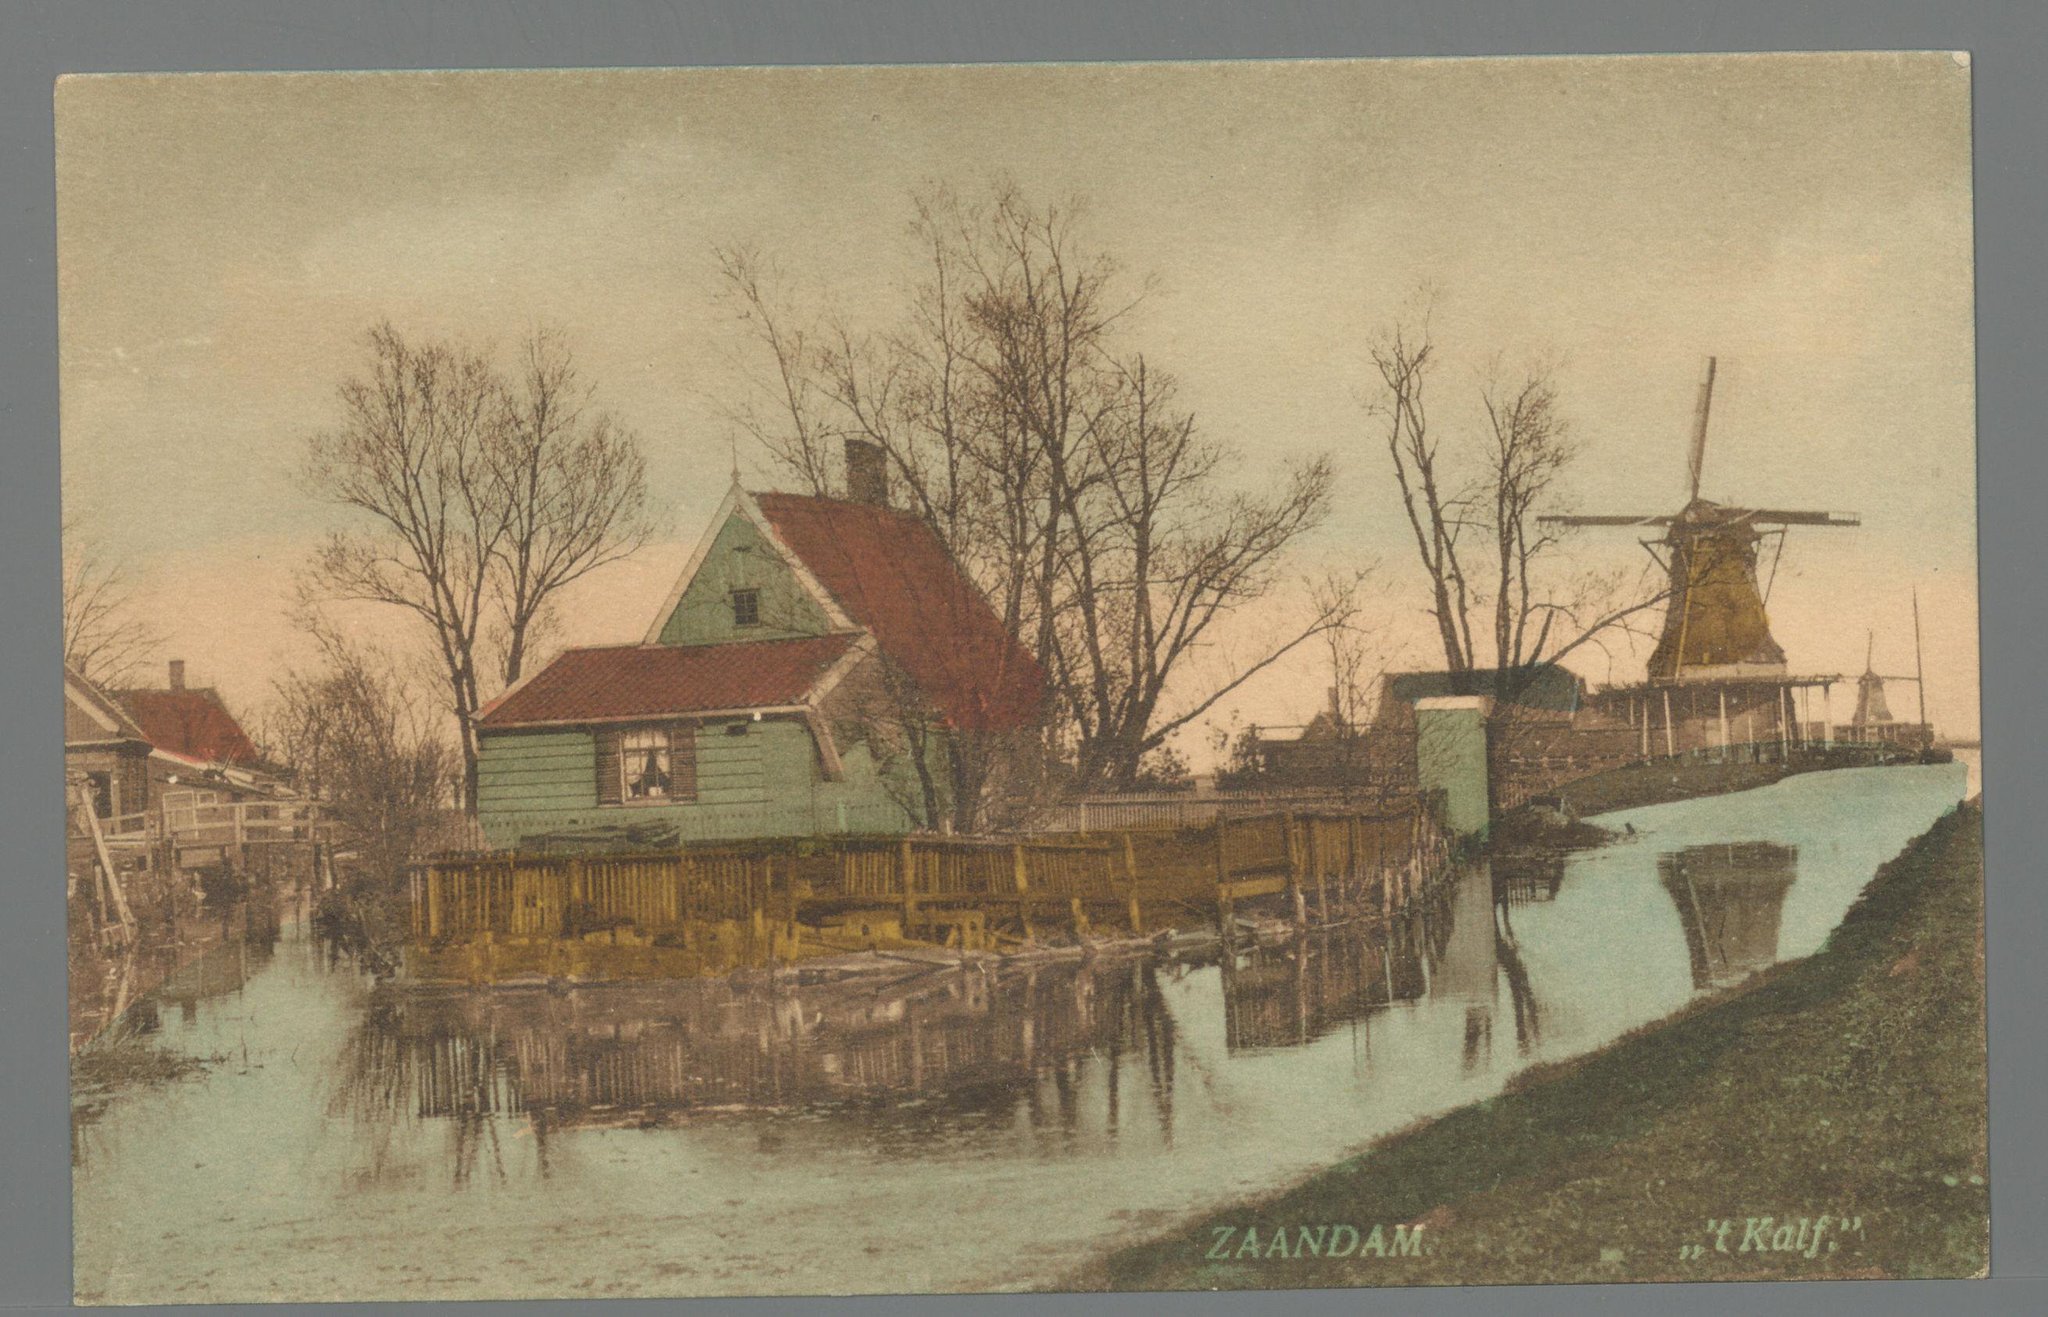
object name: ansichtkaart, prentbriefkaart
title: Zaandam. "'t Kalf"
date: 1906-1930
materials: cardboard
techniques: photograph, hand coloring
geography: amsterdam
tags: canal, windmill in landscape